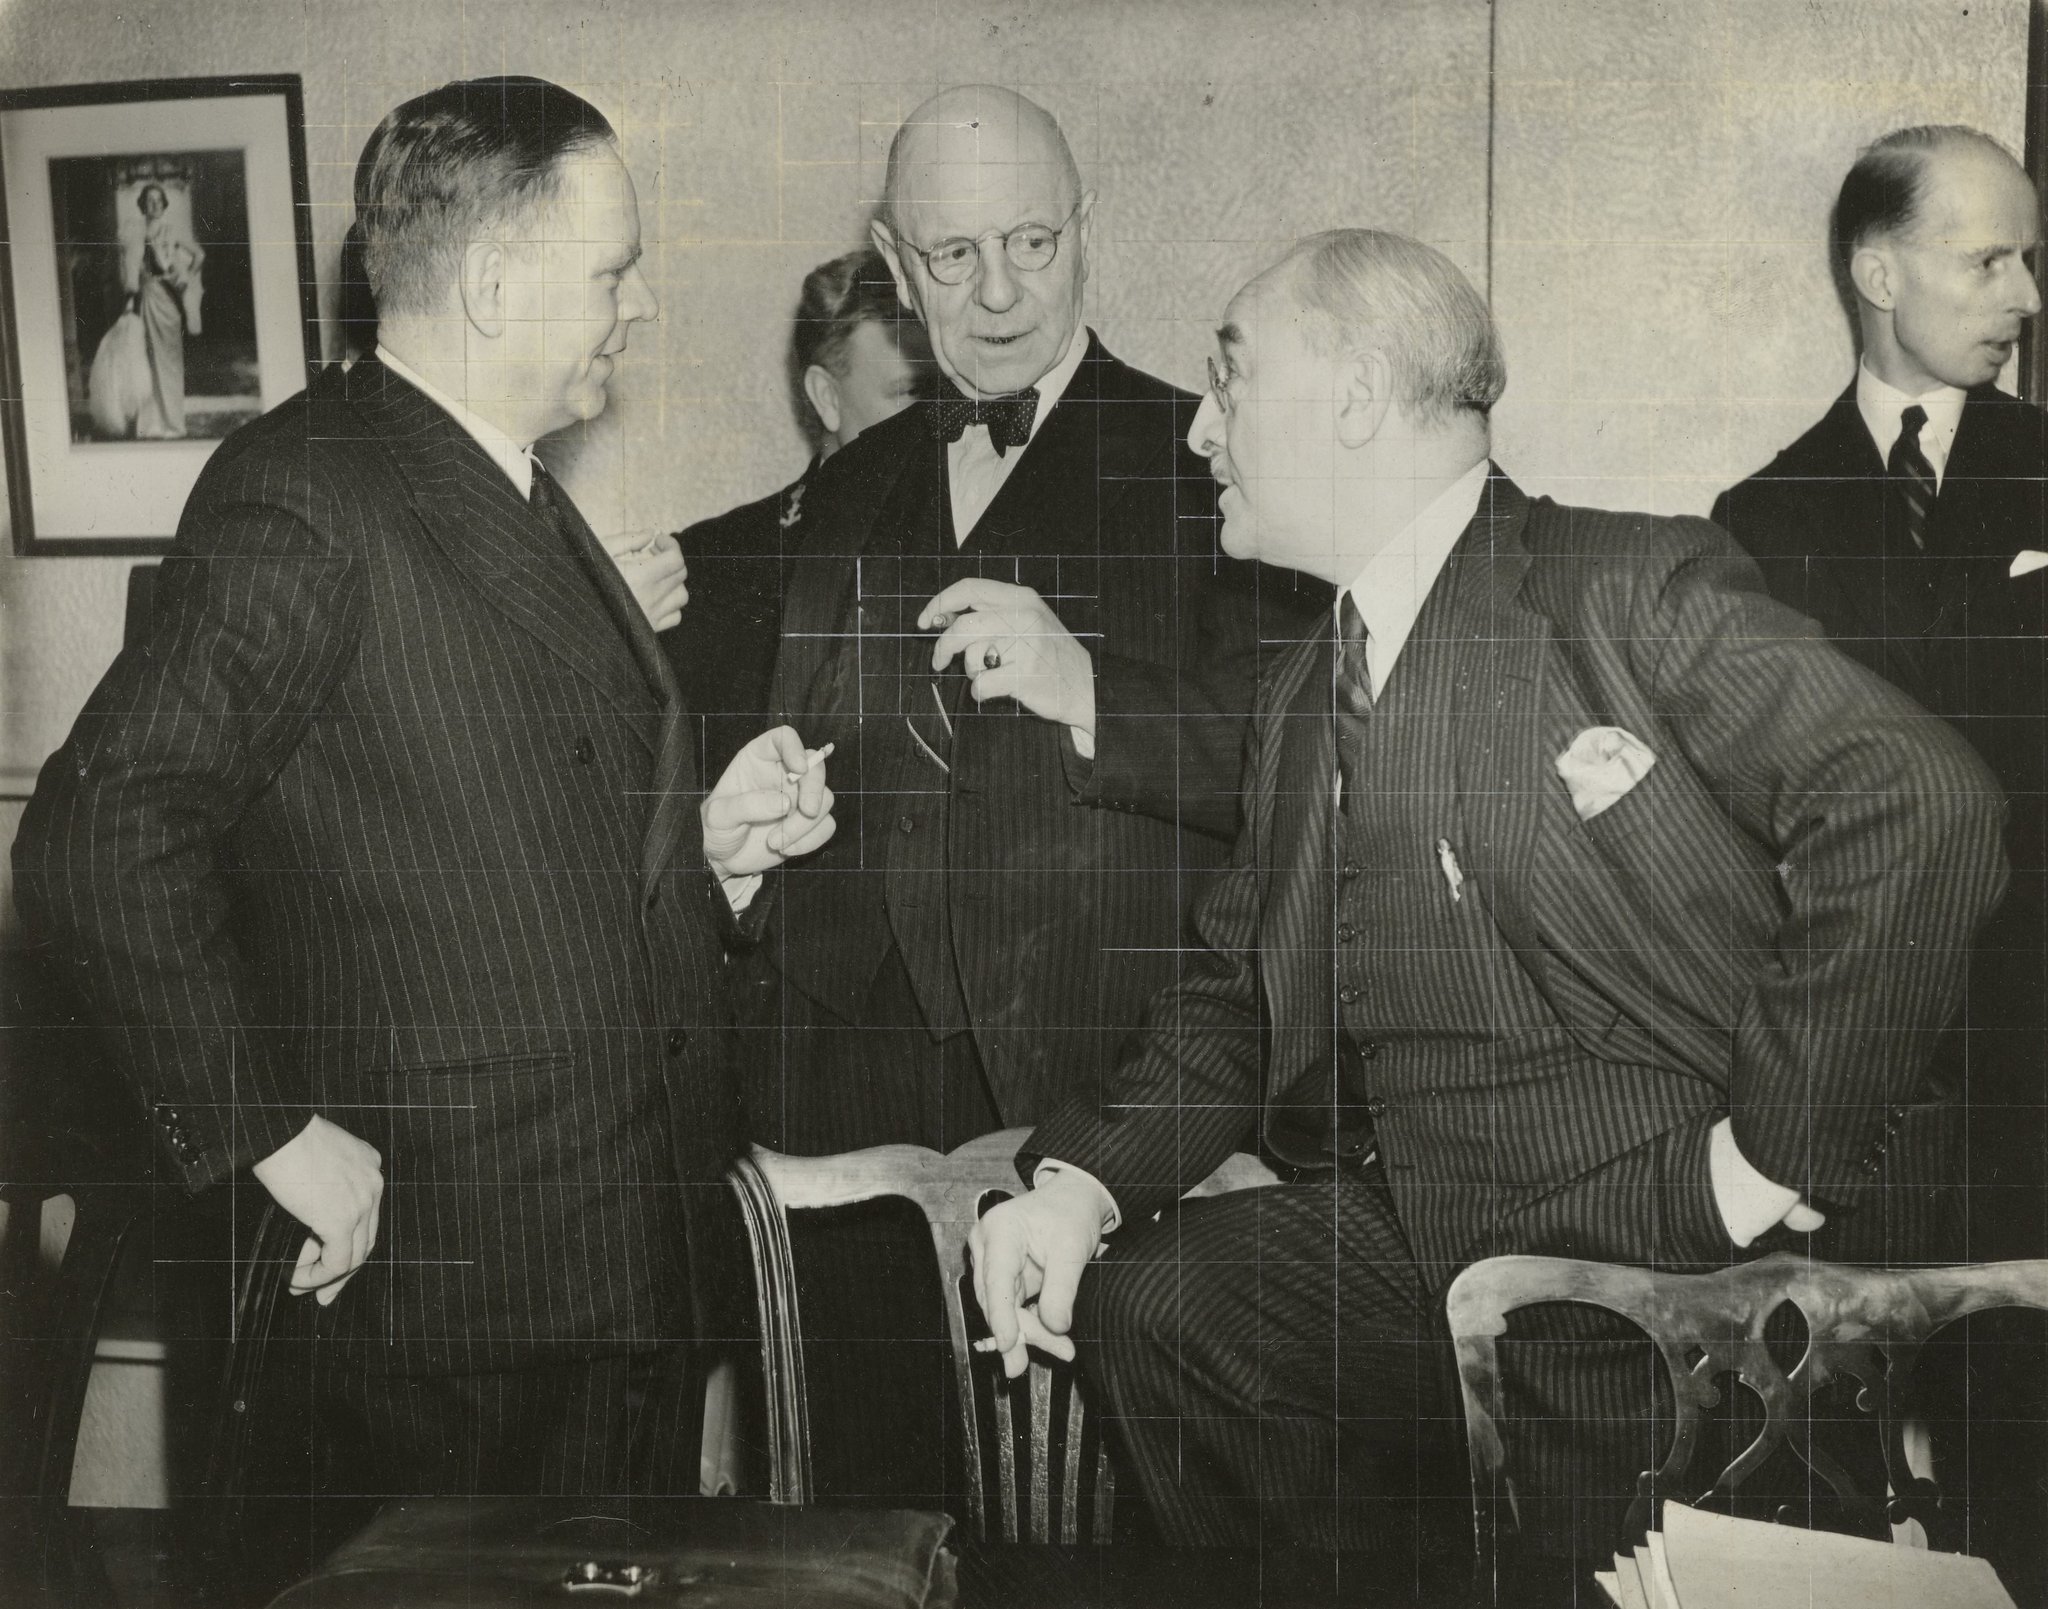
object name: photograph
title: Een groep ministers in discussie in Stratton House in Londen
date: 1940-1945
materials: photographic support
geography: london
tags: haarlem, london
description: Een groep ministers in discussie in Stratton House in Londen. V.l.n.r.: de ministers Kerstens, Albarda, Van den Broek en Van Kleffens. Deze afbeelding van minister Van den Broek (financiën) gebruikte kunstenaar Cor Visser voor het groepsportret van het tweede oorlogskabinet Gerbrandy. Het lijnennet is aangebracht door Cor Visser.